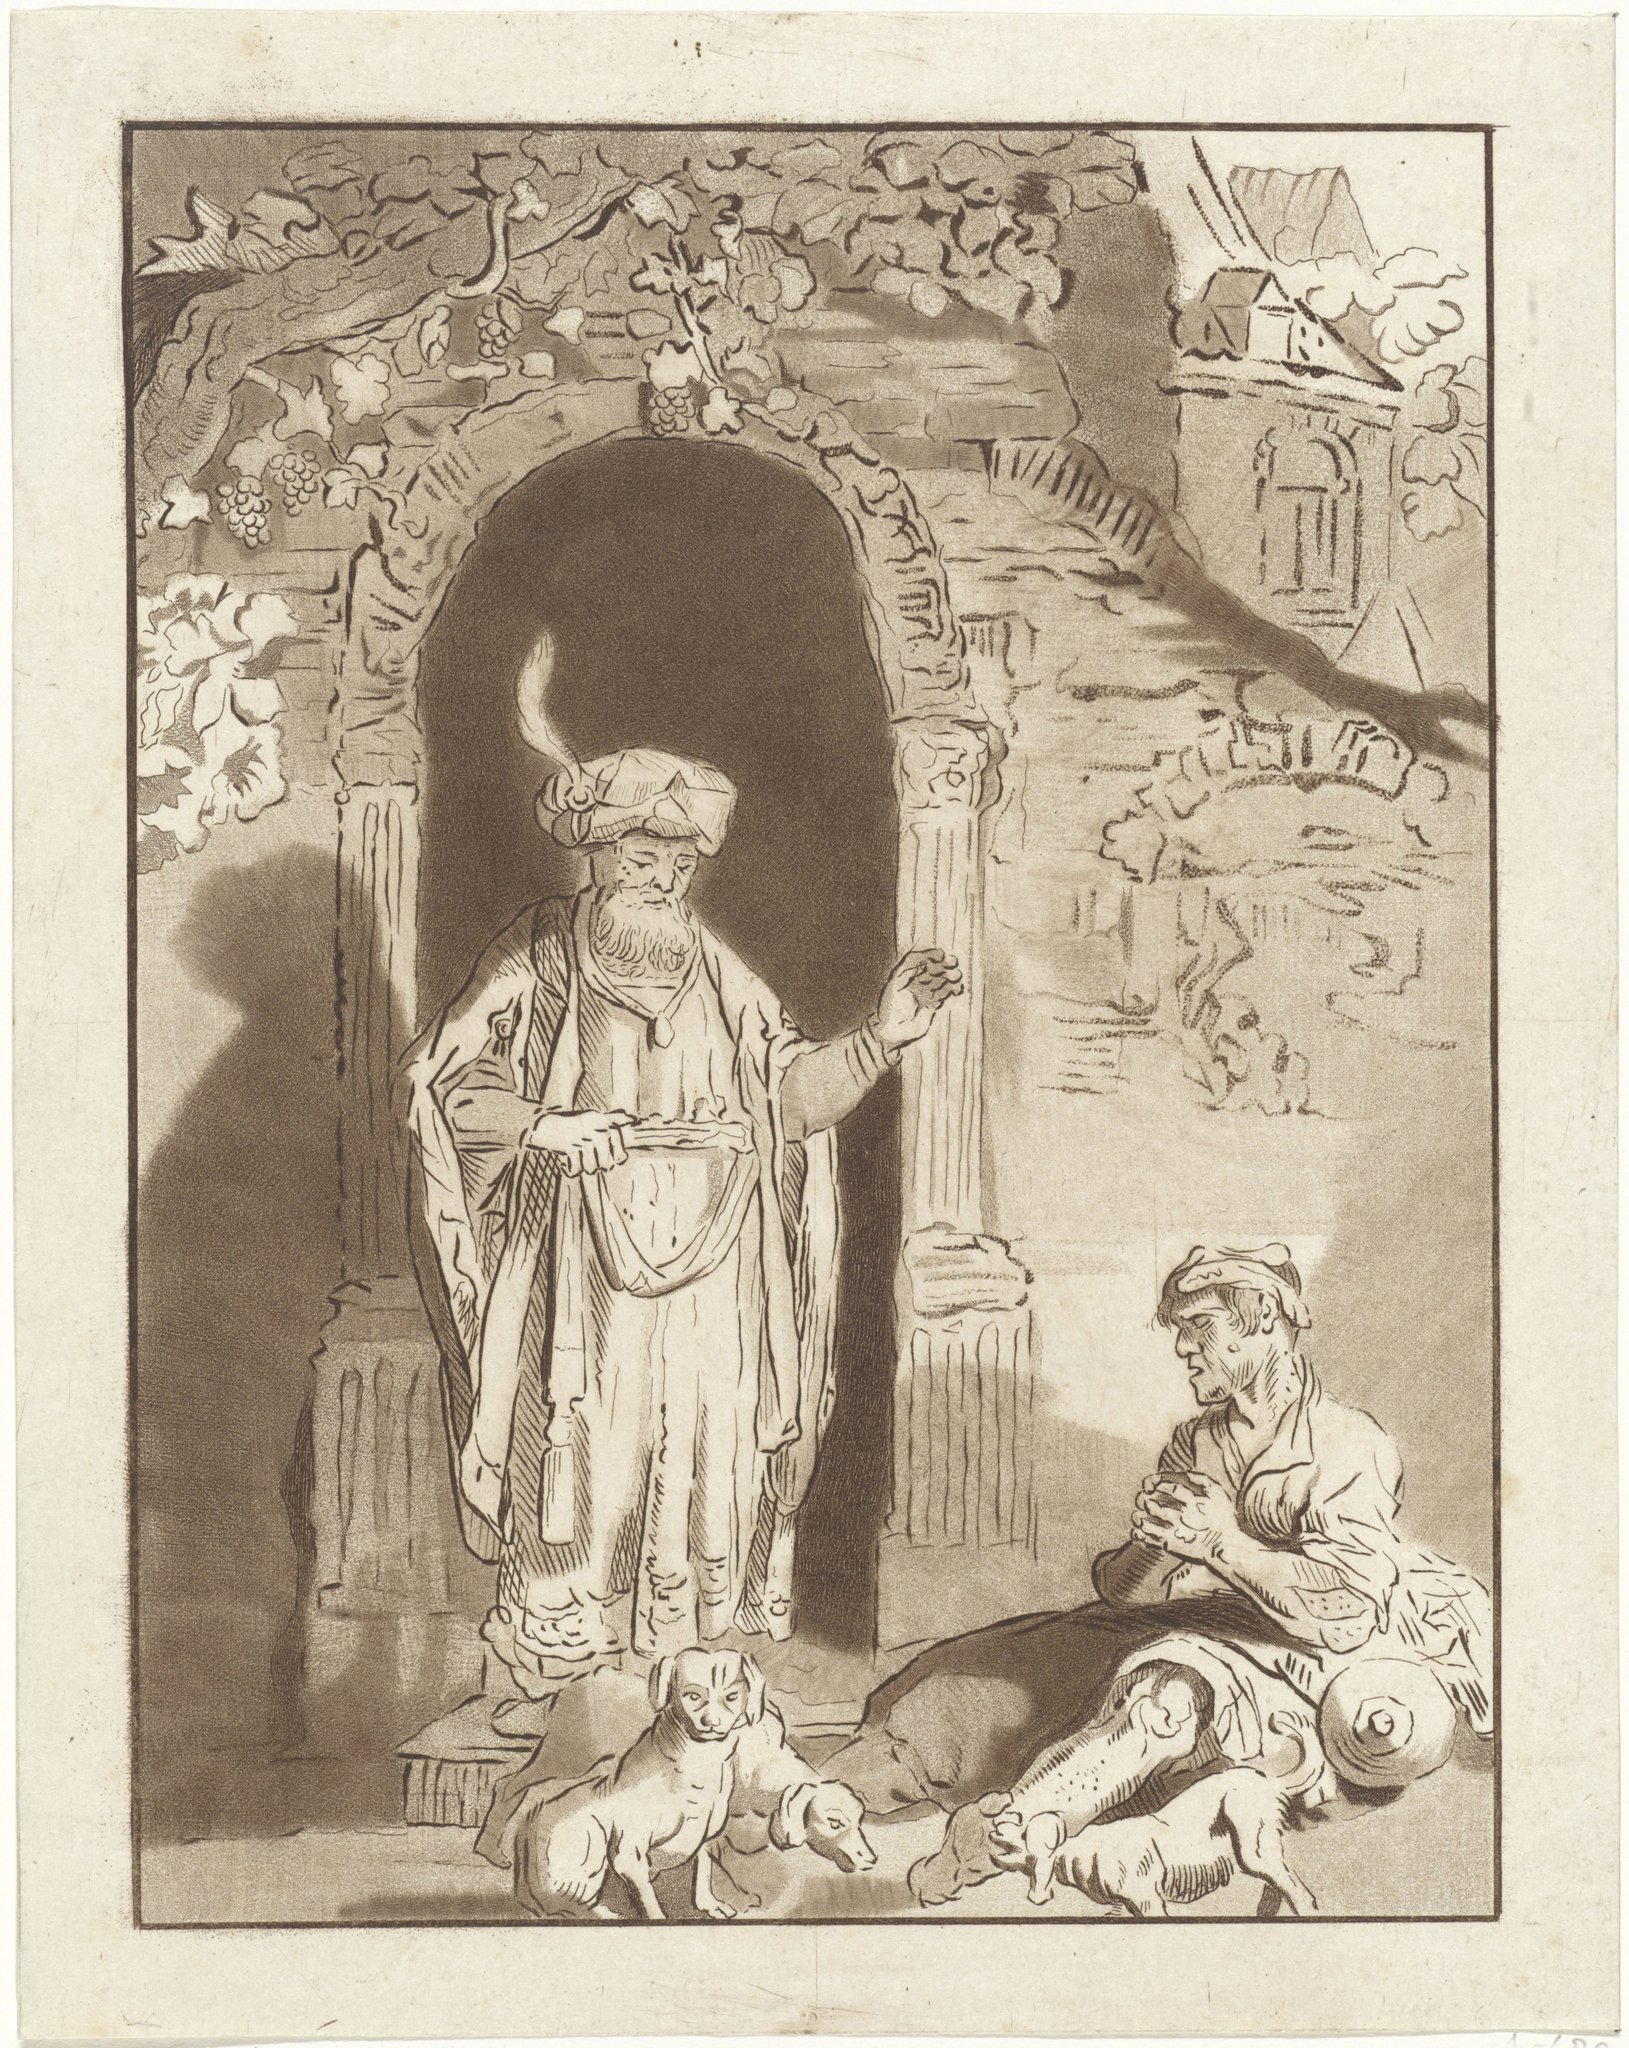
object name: print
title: De rijke man en de arme Lazarus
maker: bernhard schreuder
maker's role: print maker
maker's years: -1780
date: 1767-1780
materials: paper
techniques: etching, rocker stamped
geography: netherlands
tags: the rich man (dives) is feasting, while poor lazarus is starving at the gate (dogs licking lazarus' sores) (luke 16:19-31)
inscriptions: collector's mark: Lugt 2228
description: De rijke man staat in zijn deuropening en kijkt neer op Lazarus, die op de grond zit en wiens zweren door de honden worden gelikt.